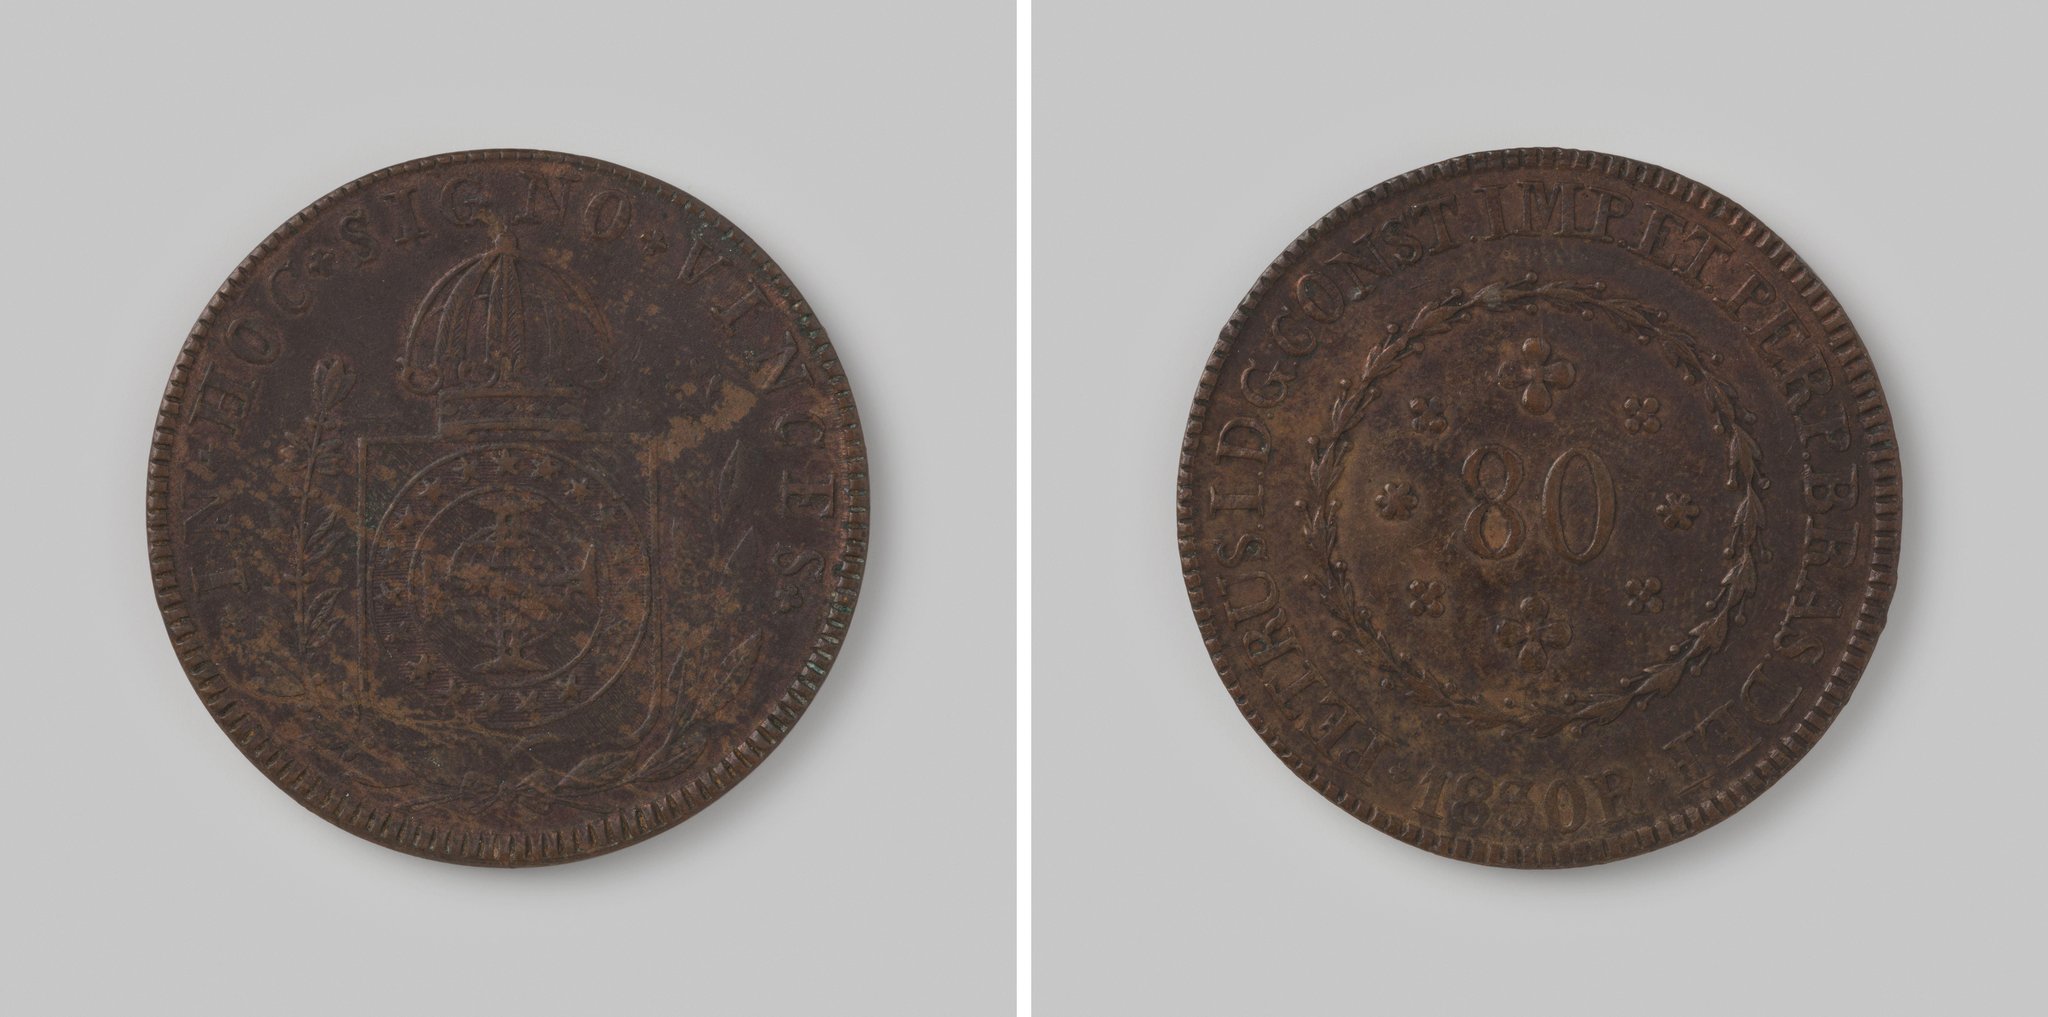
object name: coin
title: 80 reis van het keizerrijk Brazilië van D. Pedro I, 1830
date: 1830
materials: copper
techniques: striking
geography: rio de janeiro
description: Koperen munt. Voorzijde: tussen twee samengebonden takken gekroond wapenschild van Brazilië. Keerzijde: binnen cirkel van bloemen waarde-aanduiding: 80. In omschrift onderaan jaartal met rechts daarvan letter R [=Rio]. Kartelrand in gleuf.